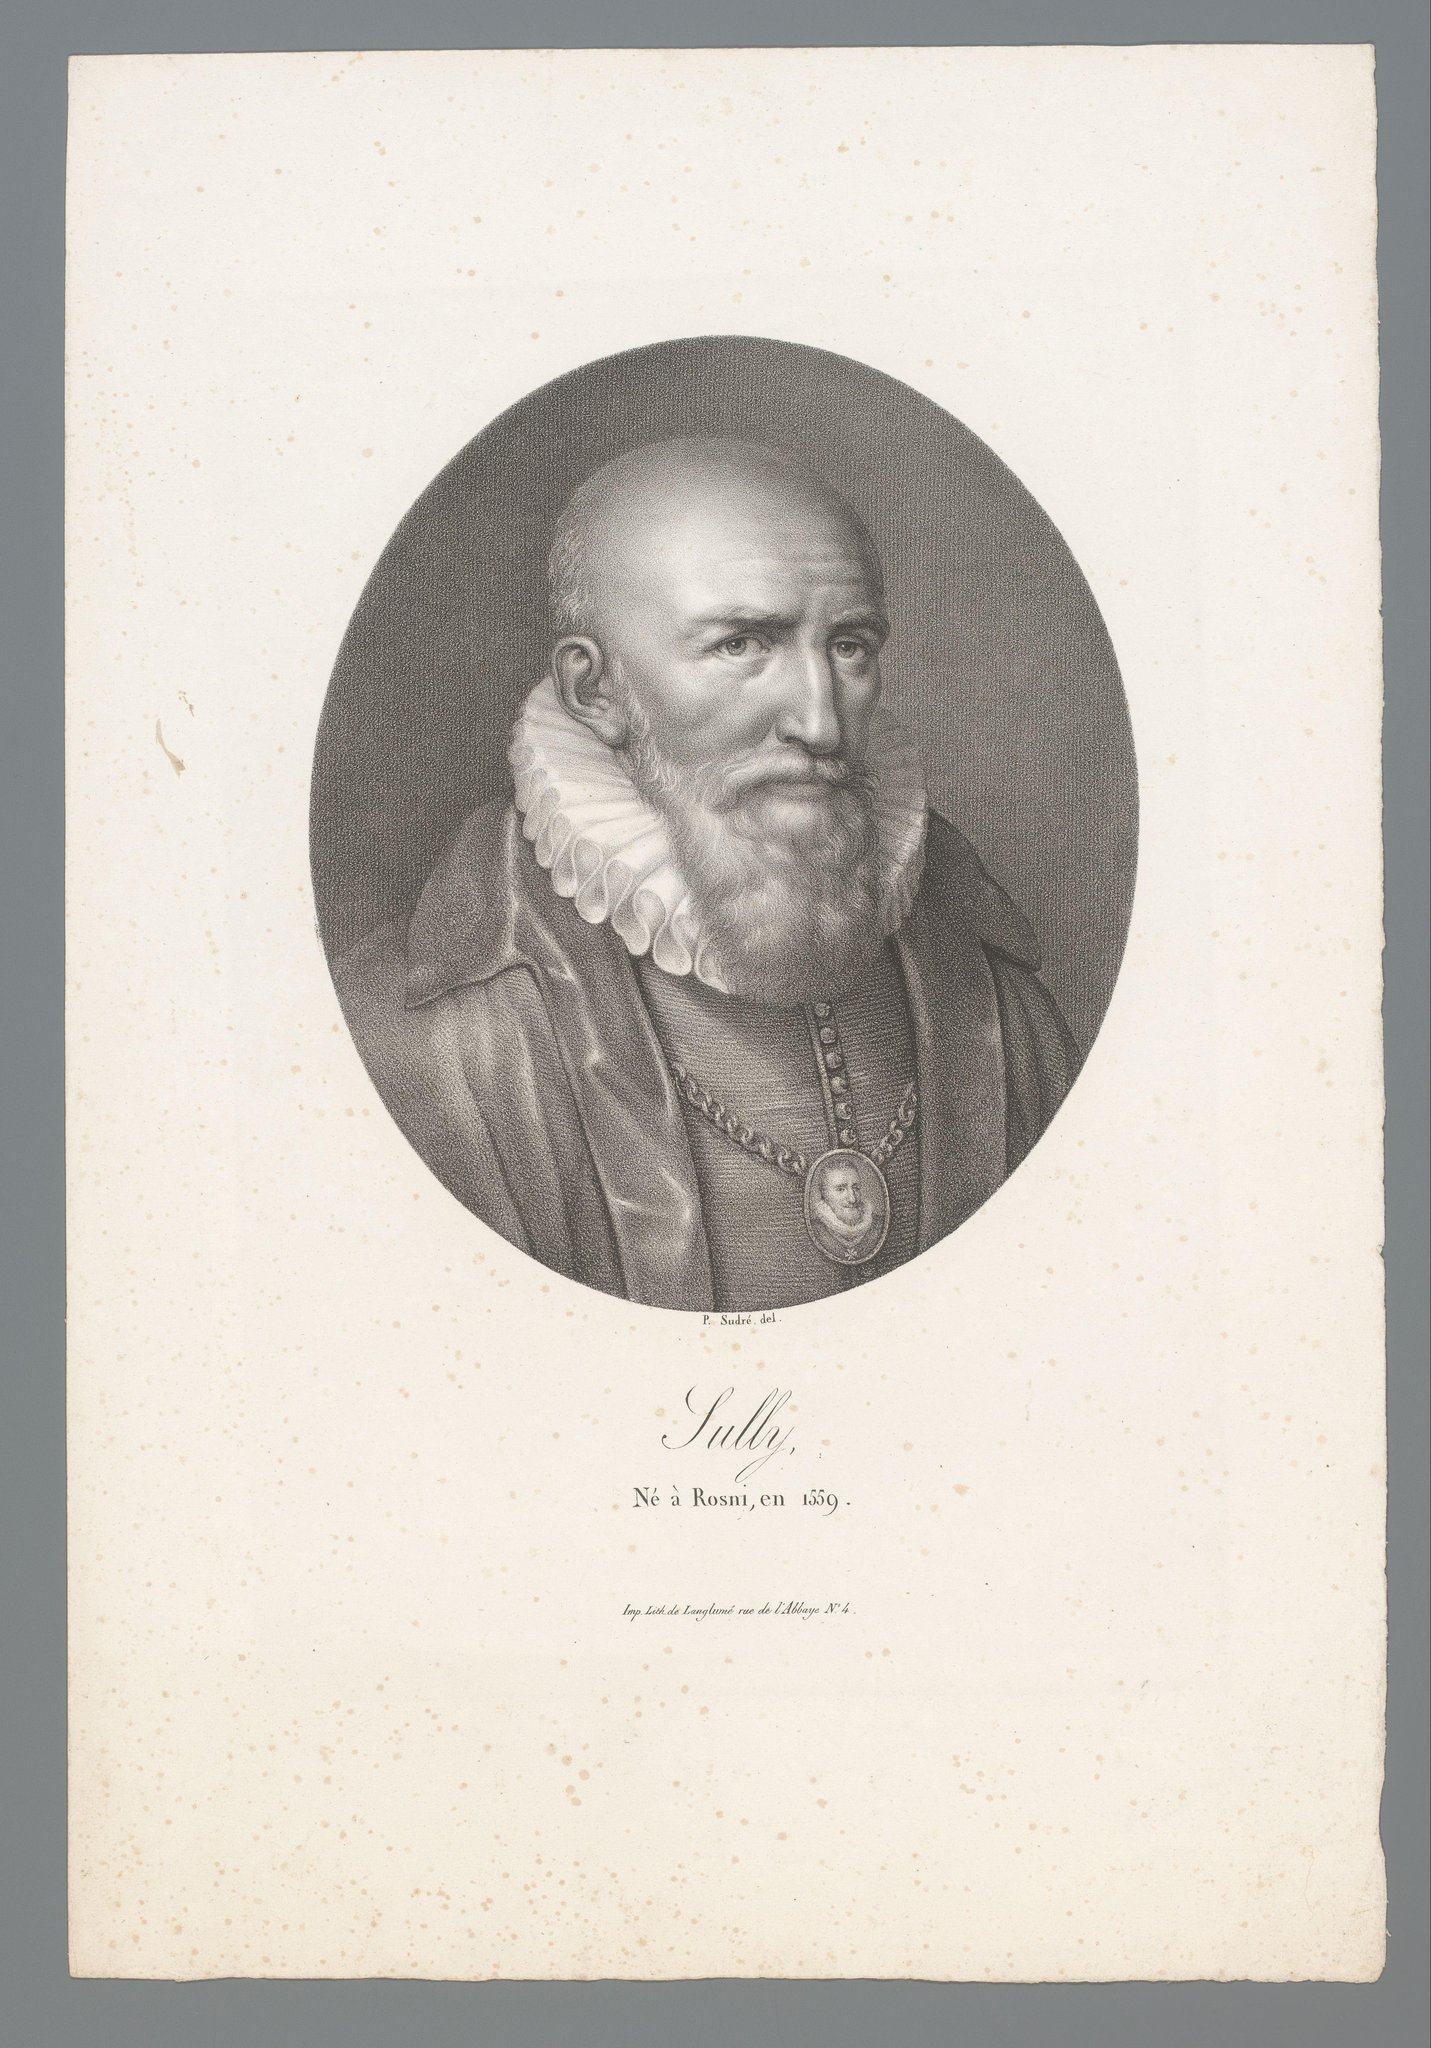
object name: print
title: Sully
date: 1822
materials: paper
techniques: lithograph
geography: paris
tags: maximilien de béthune (duke of sully), historical persons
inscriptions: collector's mark: Lugt 2228